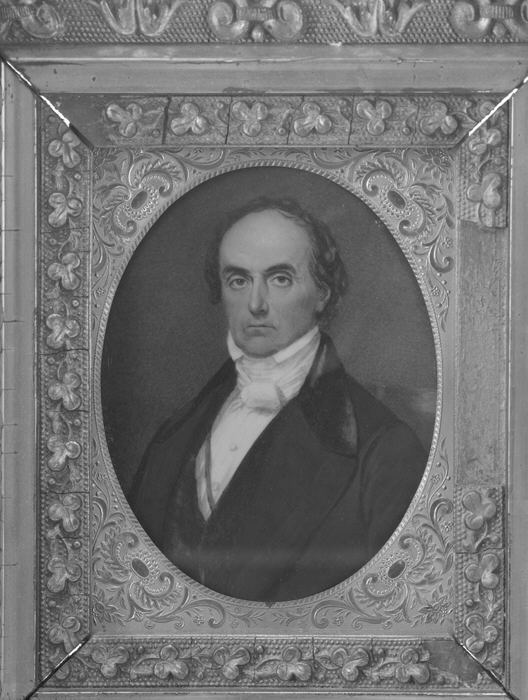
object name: painting, miniature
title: Daniel Webster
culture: american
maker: george harrison hite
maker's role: artist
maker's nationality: american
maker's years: 1807-1880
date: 1844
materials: ivory, watercolor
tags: men,portraits